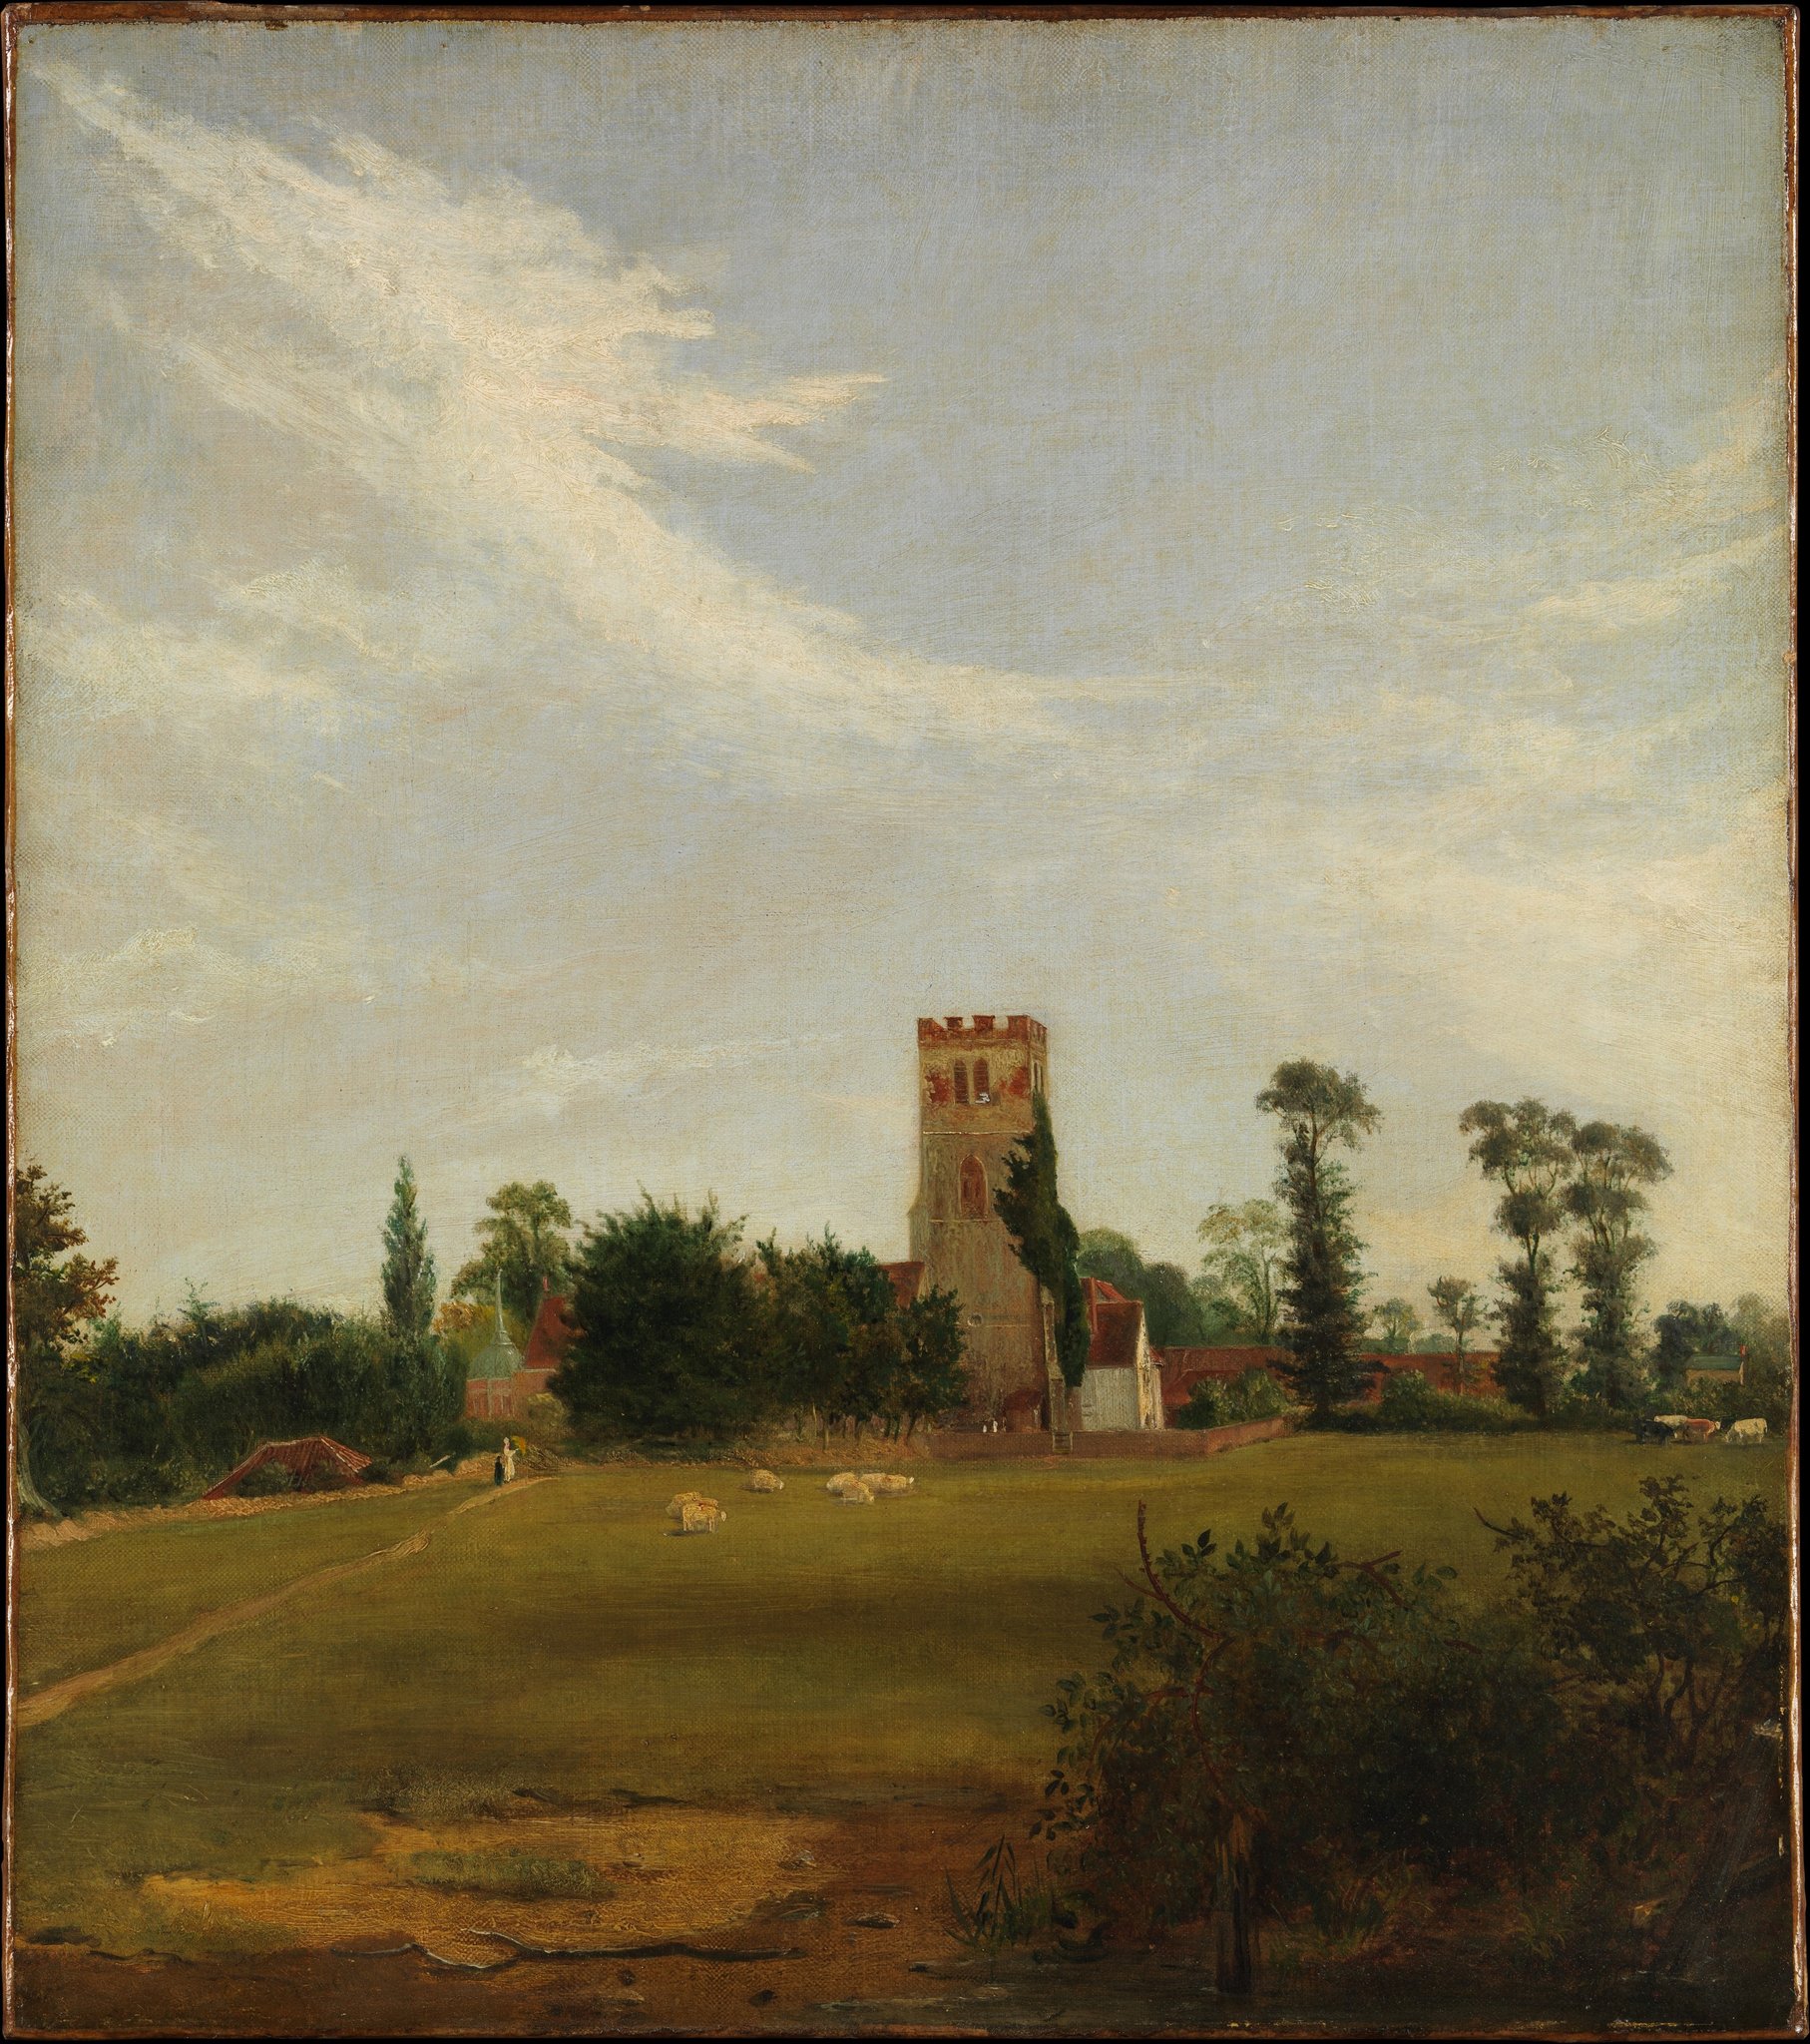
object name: painting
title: Tottenham Church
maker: british painter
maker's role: artist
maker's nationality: british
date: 1825-1835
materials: canvas, oil